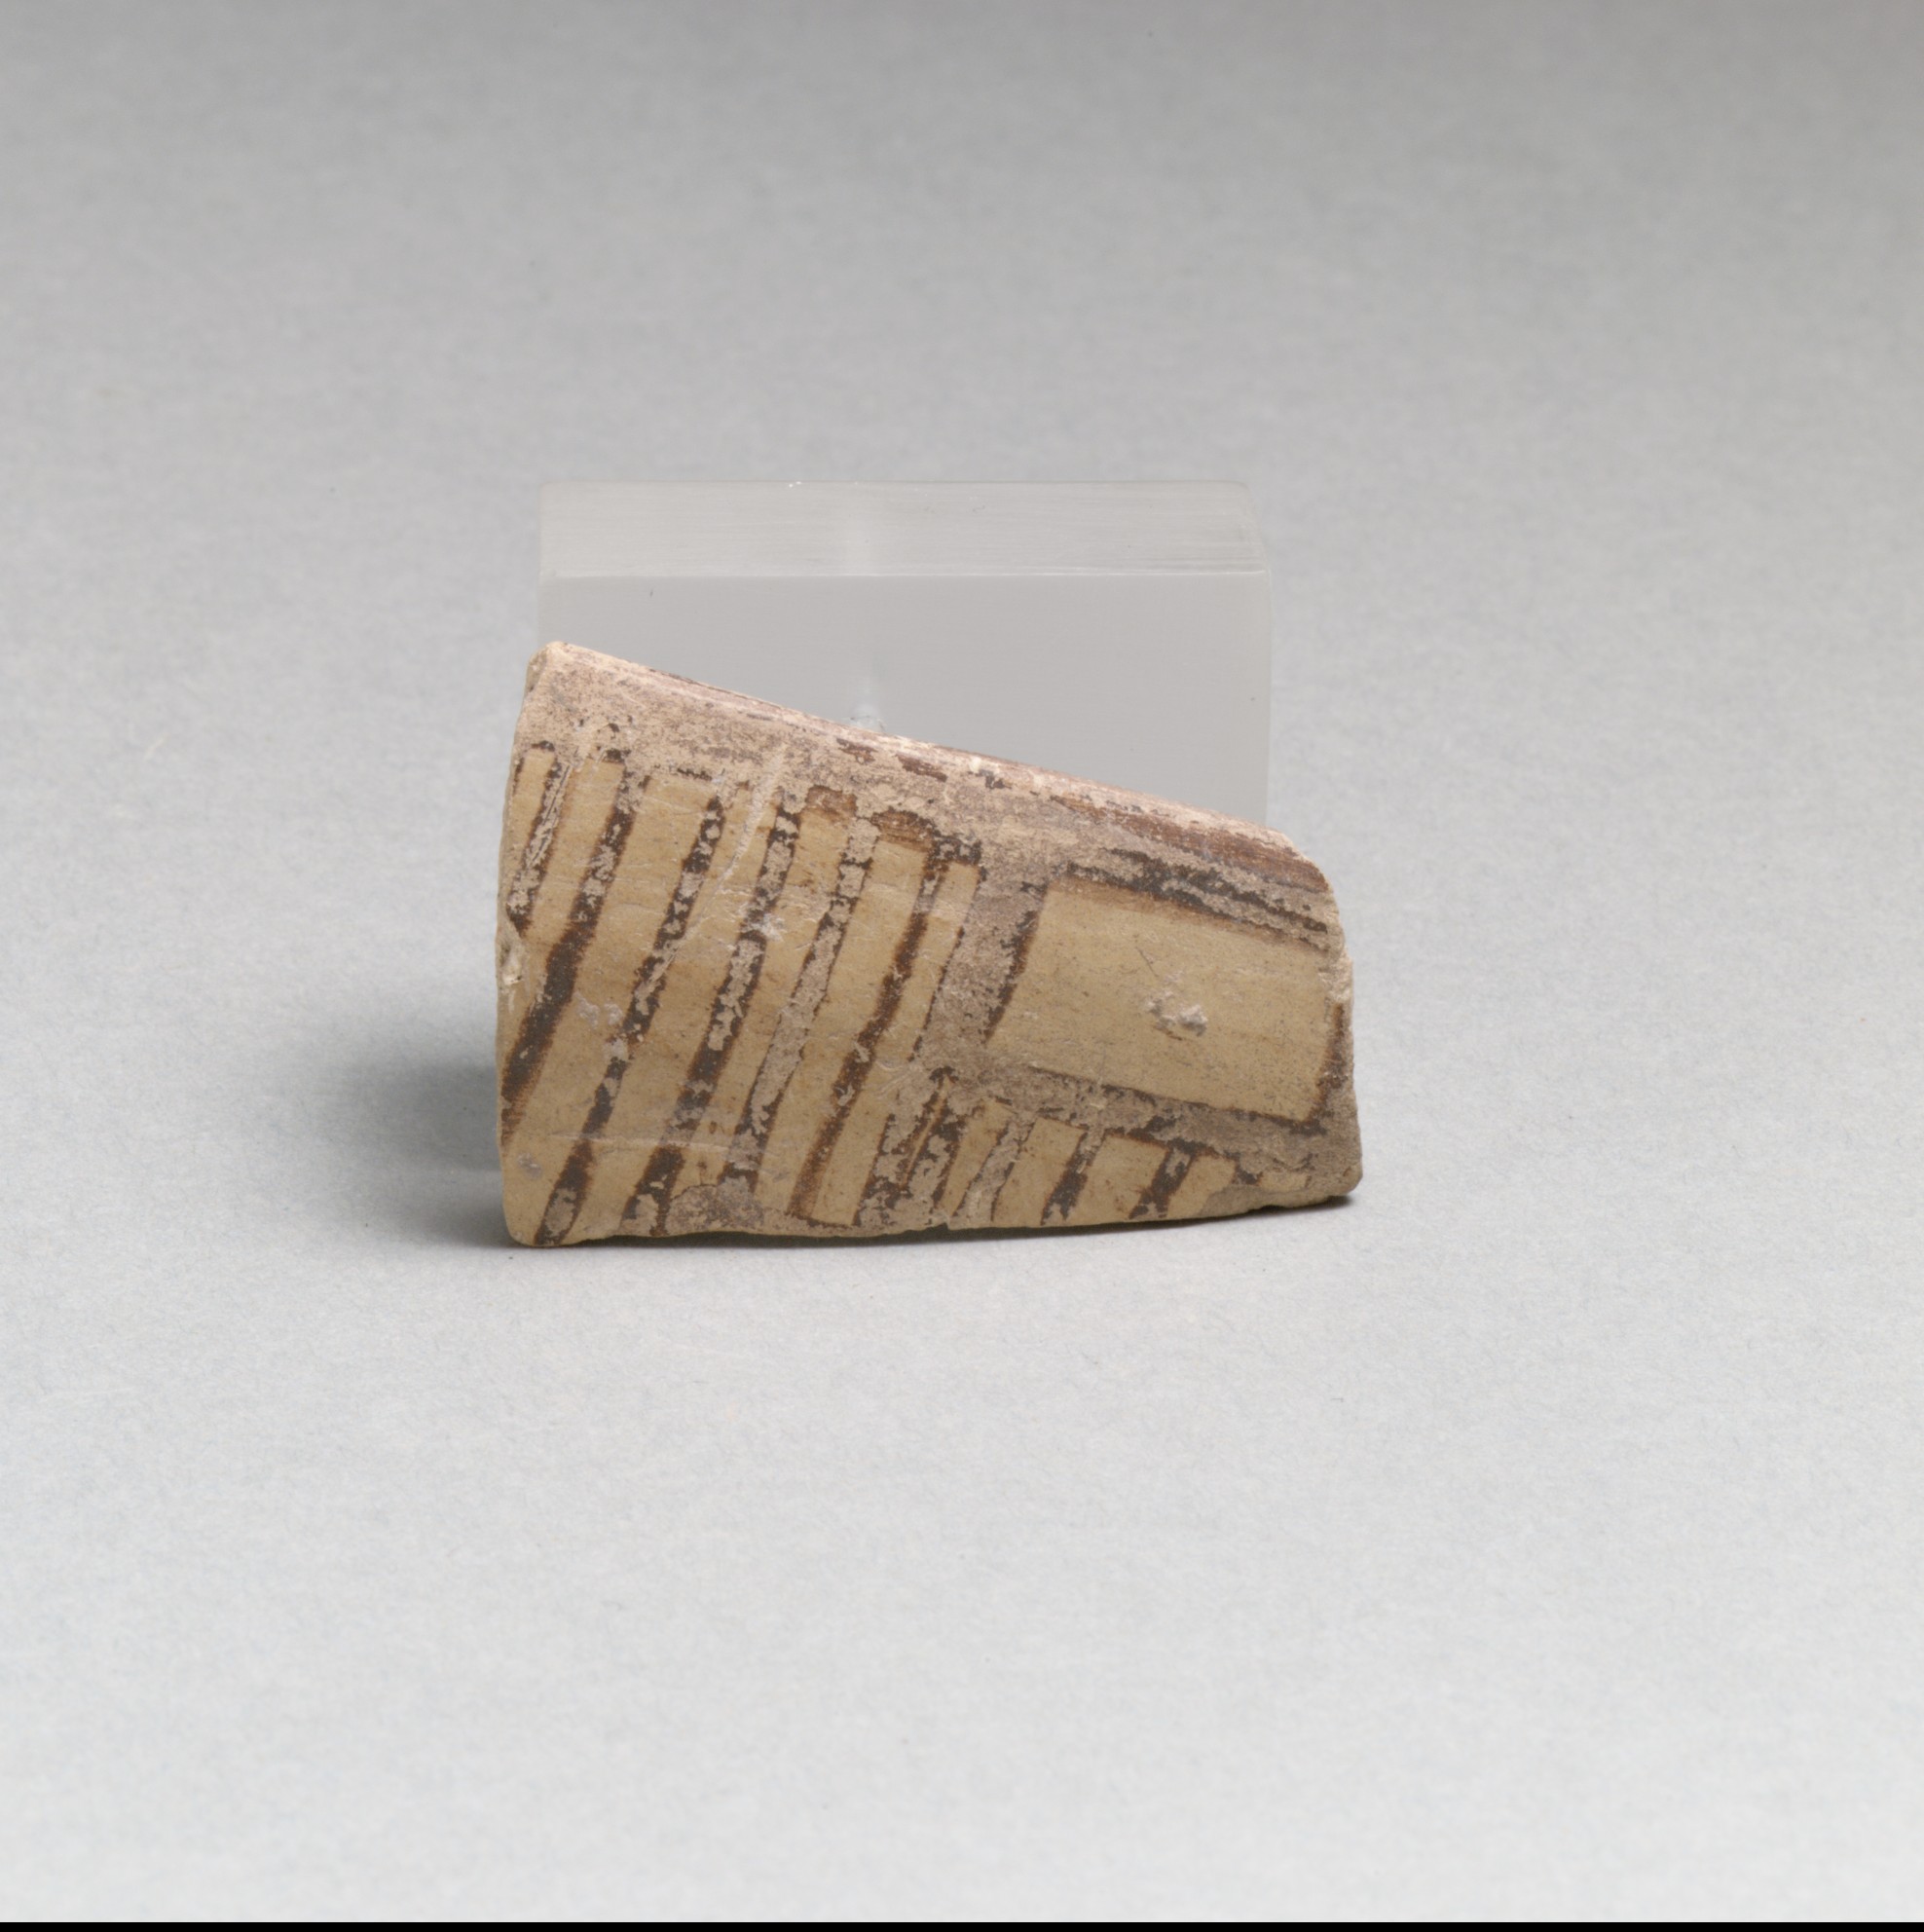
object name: vase fragment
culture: neolithic, thessaly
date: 4000-3000 BCE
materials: terracotta